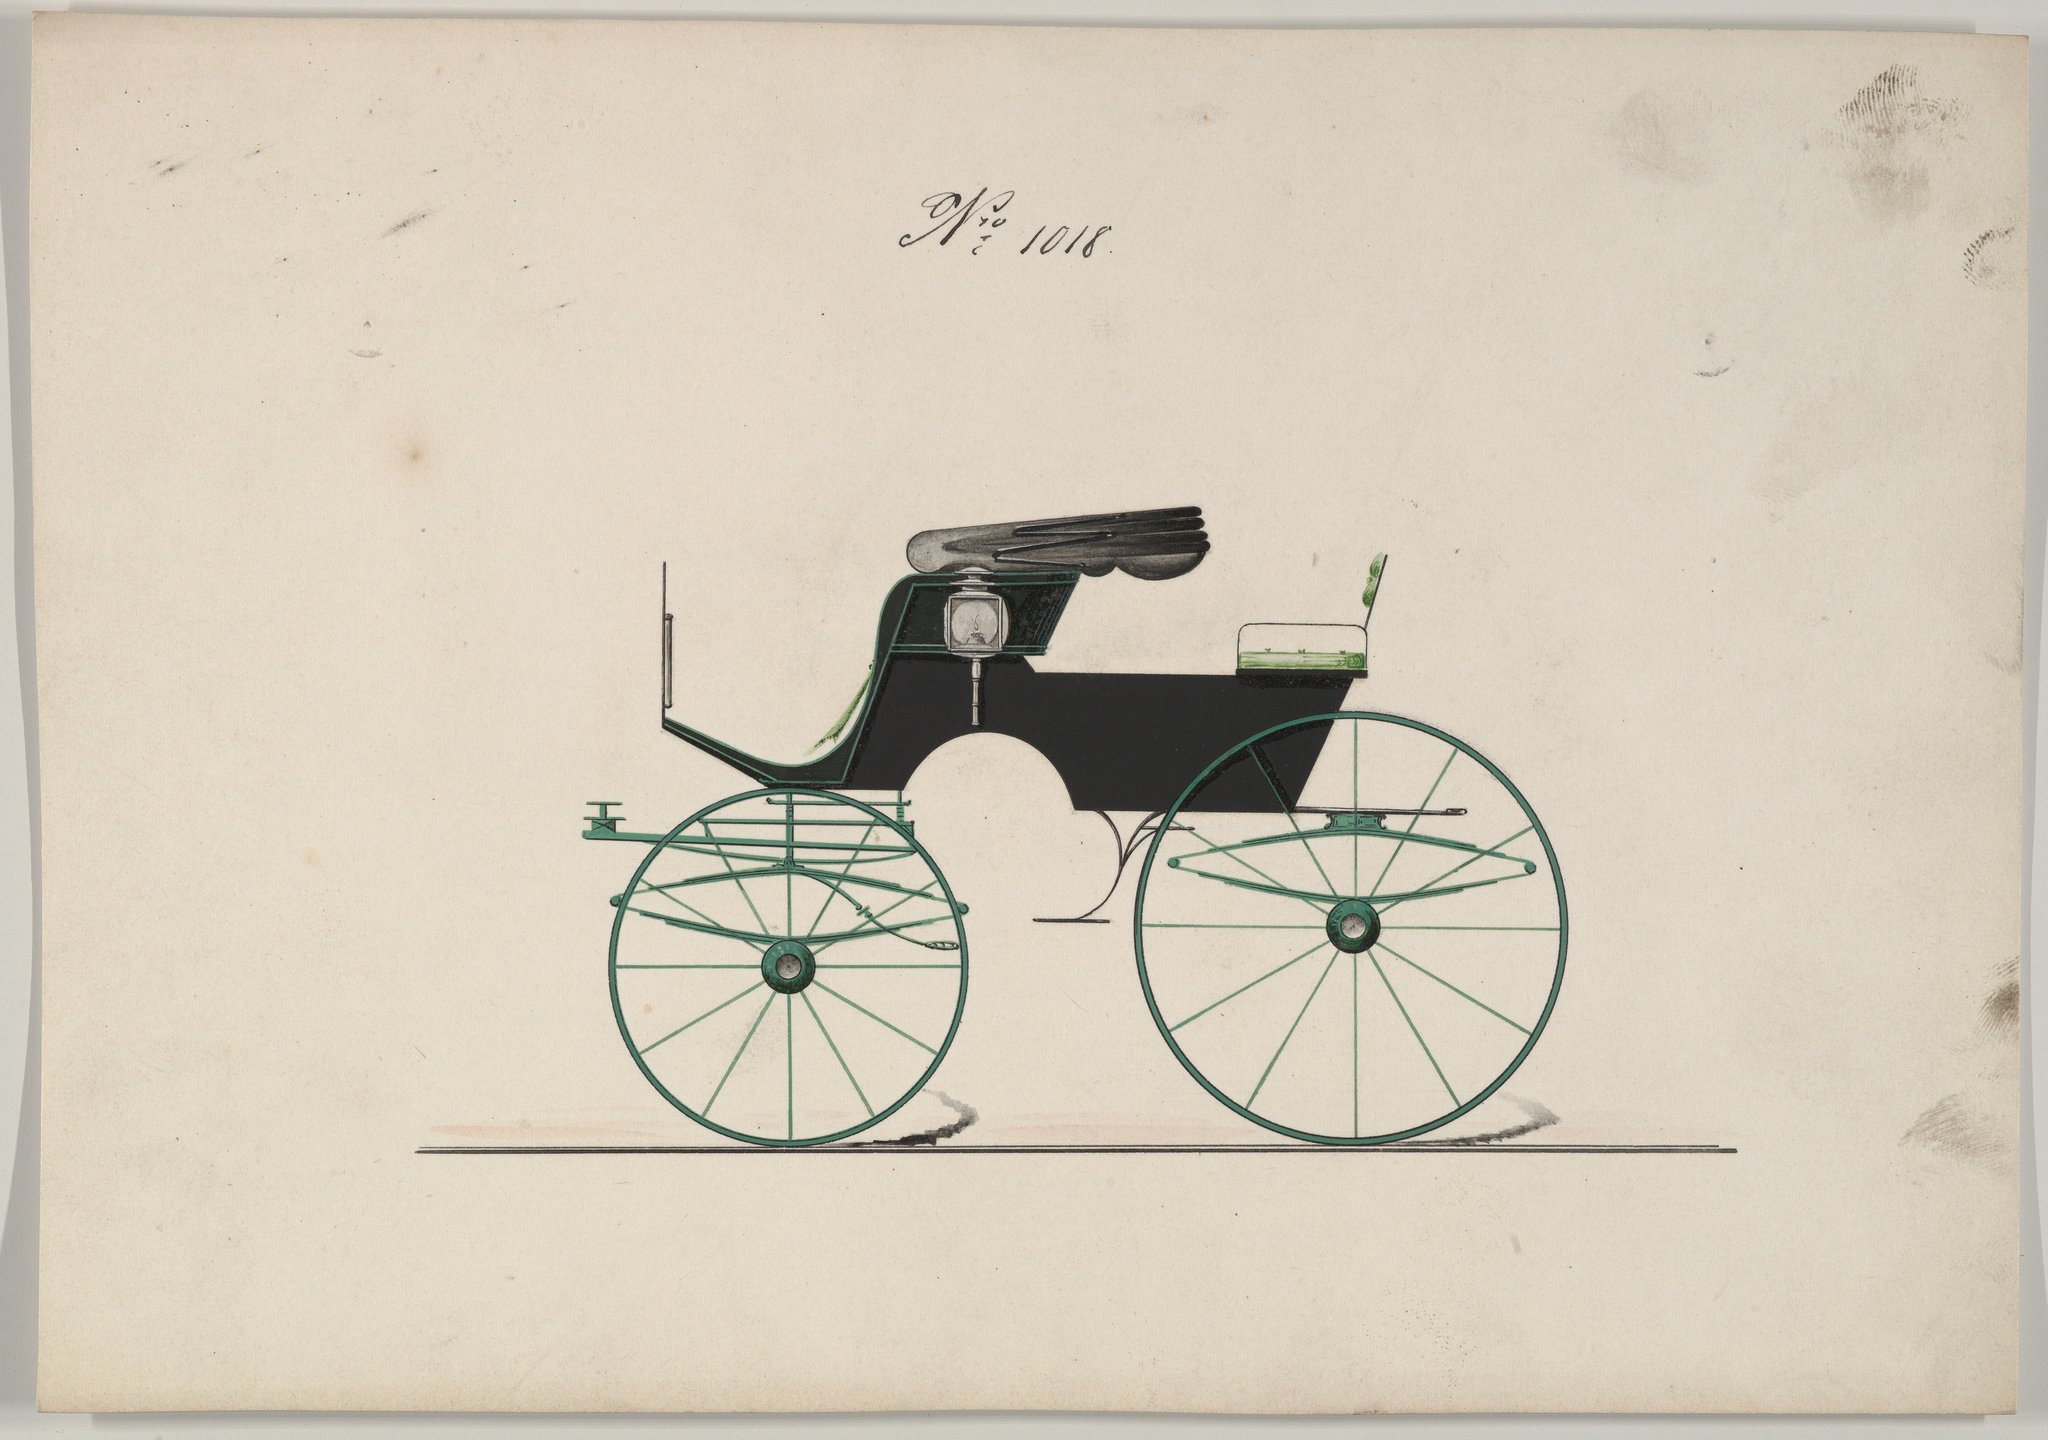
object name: drawing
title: Design for Stanhope Phaeton, no. 1018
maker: brewster & co.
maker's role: manufacturer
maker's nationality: american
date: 1850-1874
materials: gouache, gum arabic, ink, watercolor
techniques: pen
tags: carriages